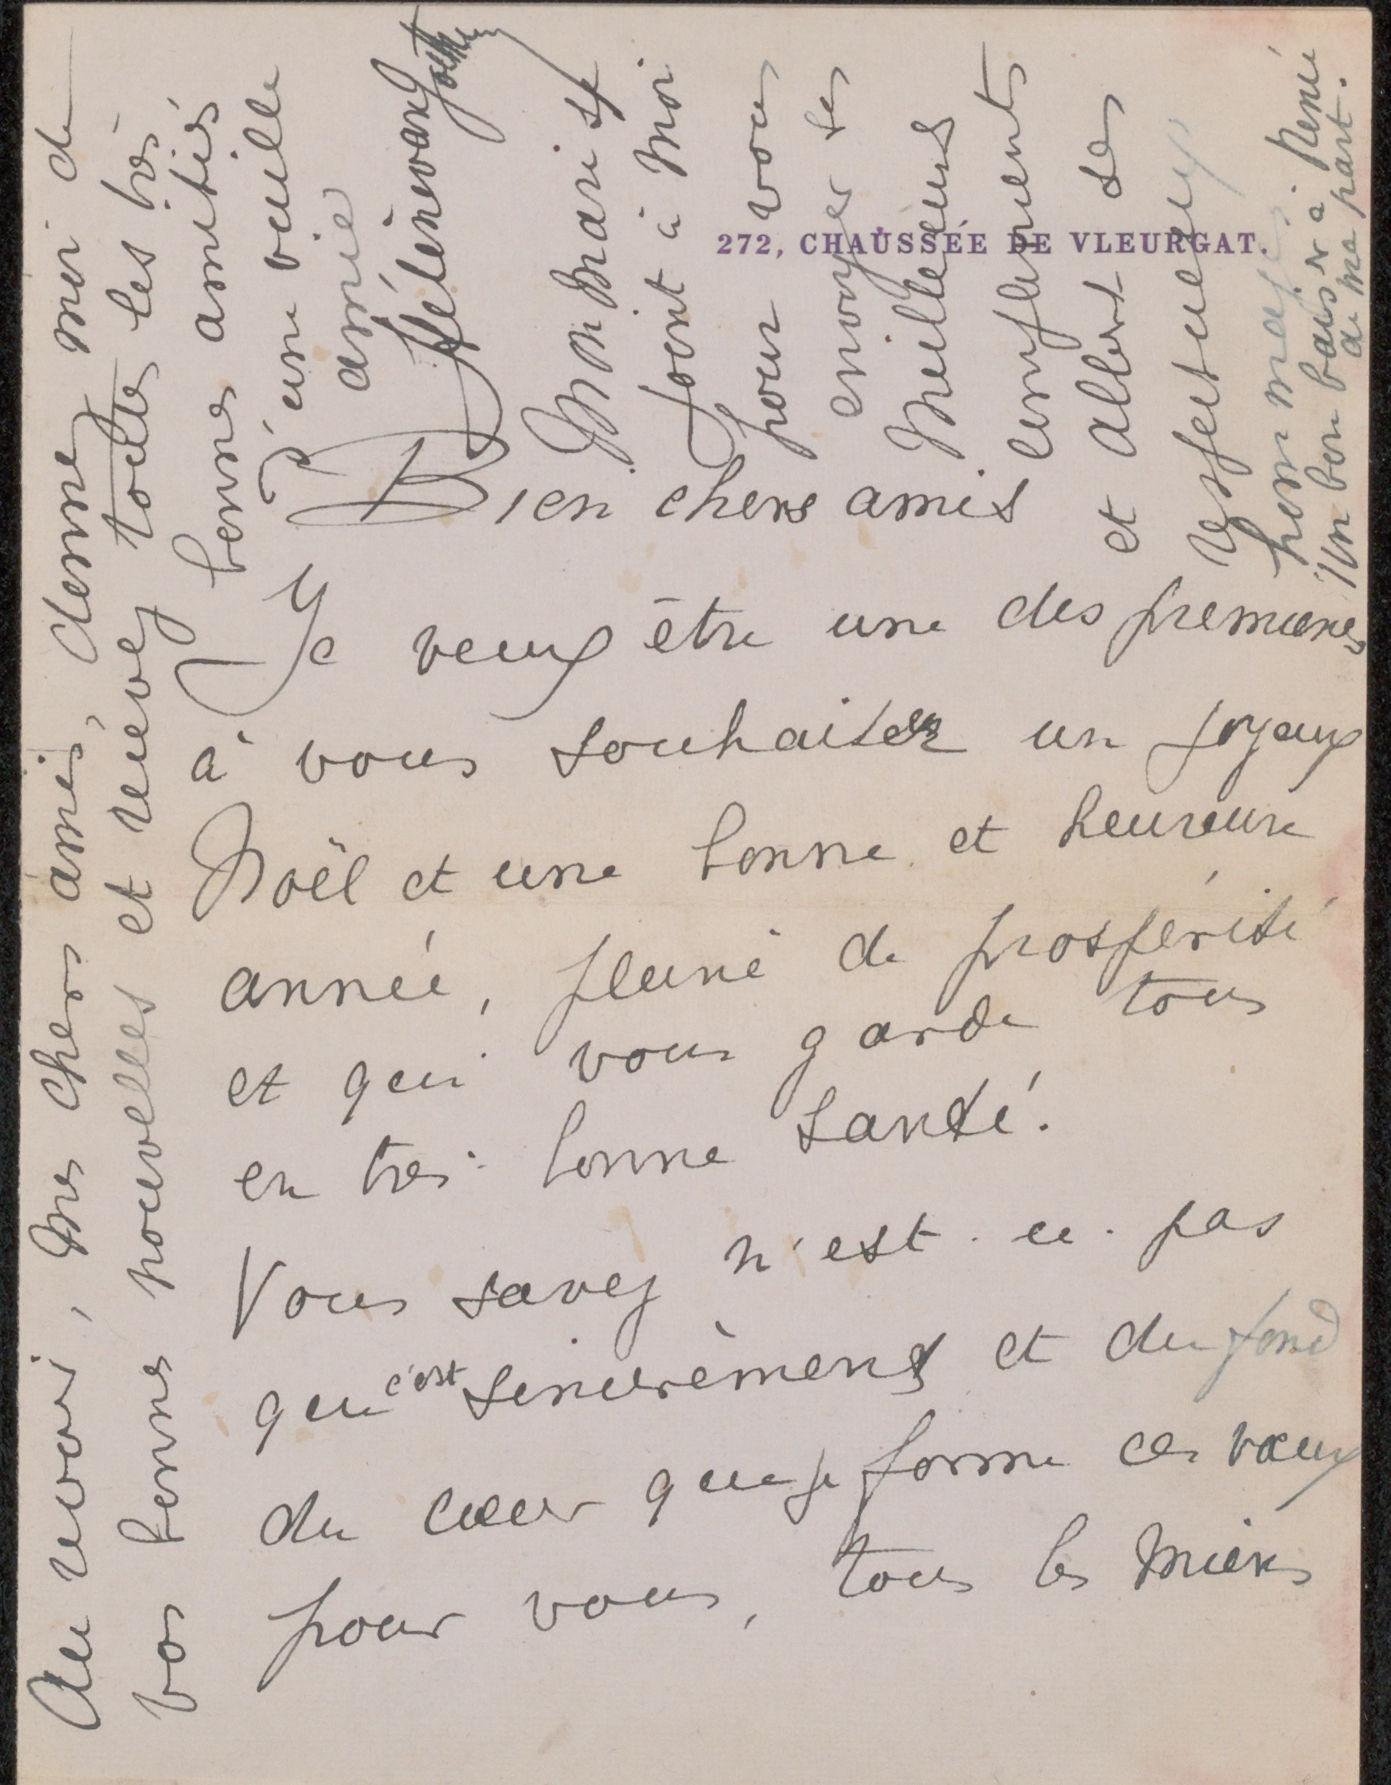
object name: letter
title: Brief aan Philip Zilcken en Henriette Wilhelmina van Baak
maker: hélène van goethem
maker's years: 1866-1919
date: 1911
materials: ink, paper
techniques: pen, printing, writing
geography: elsene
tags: voorburg, renée hélène laure zilcken, henriette wilhelmina van baak, painter, draughtsman, philip zilcken, brussels